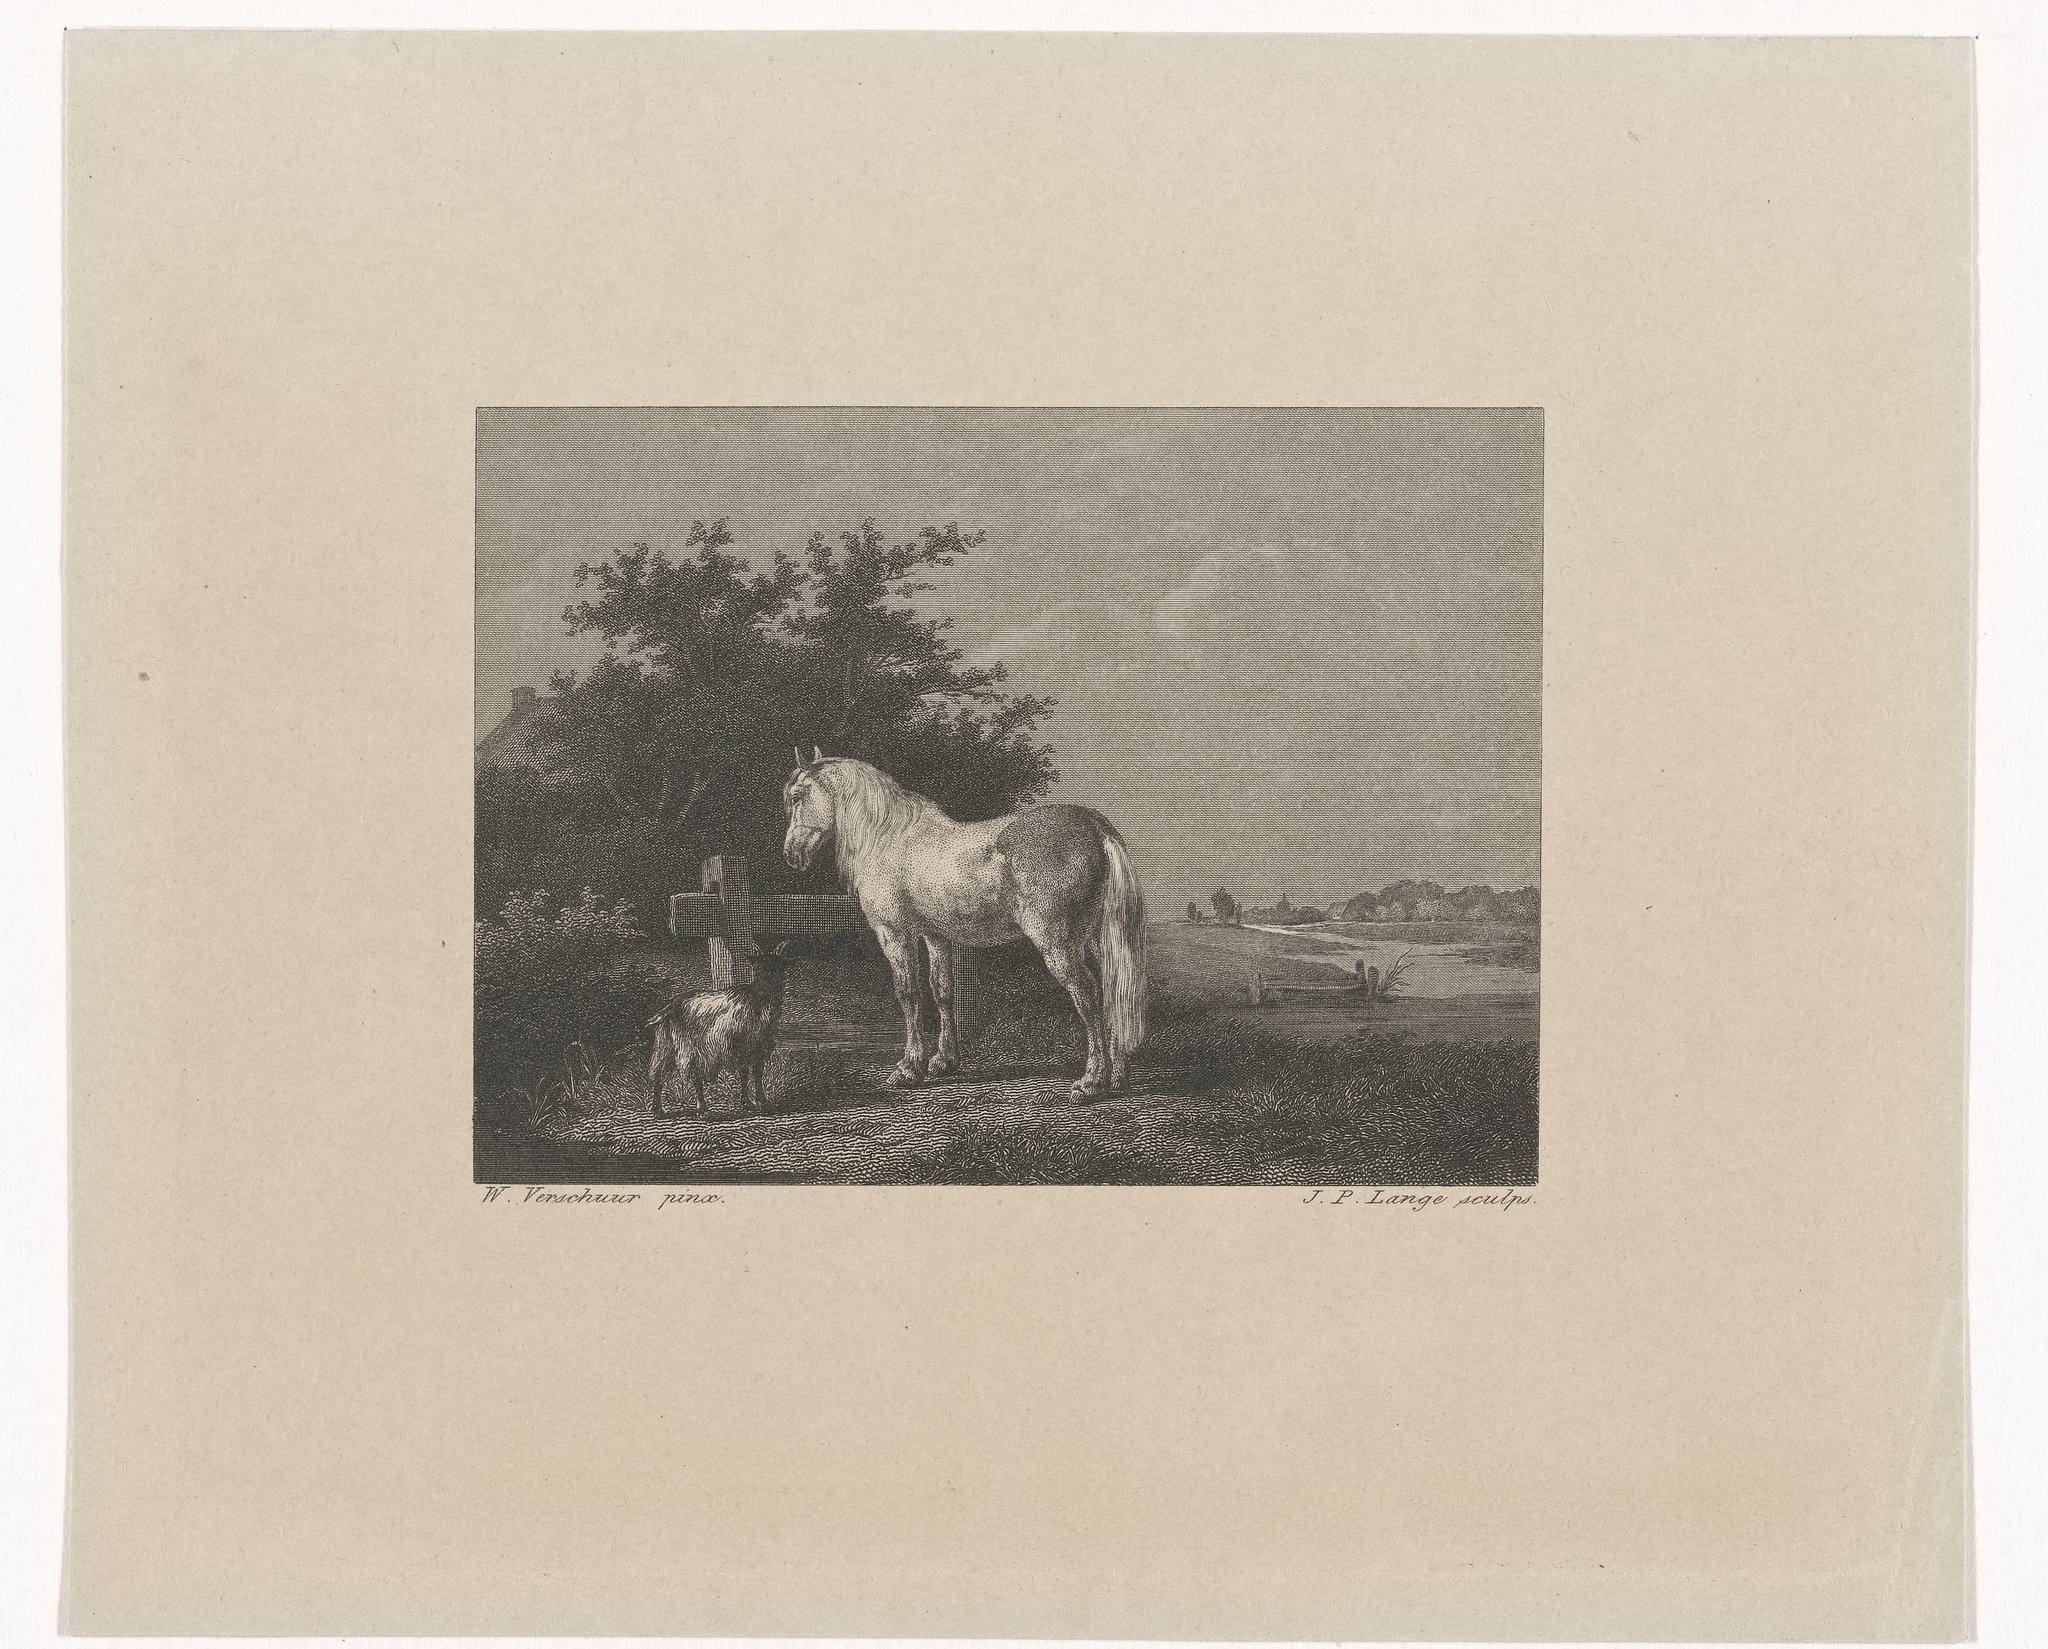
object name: print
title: Paard en geit in de wei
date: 1820-1849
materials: paper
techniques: engraving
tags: horses and kindred animals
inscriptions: collector's mark: Lugt 2228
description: Een paard en een geit staan in de wei voor een hek.